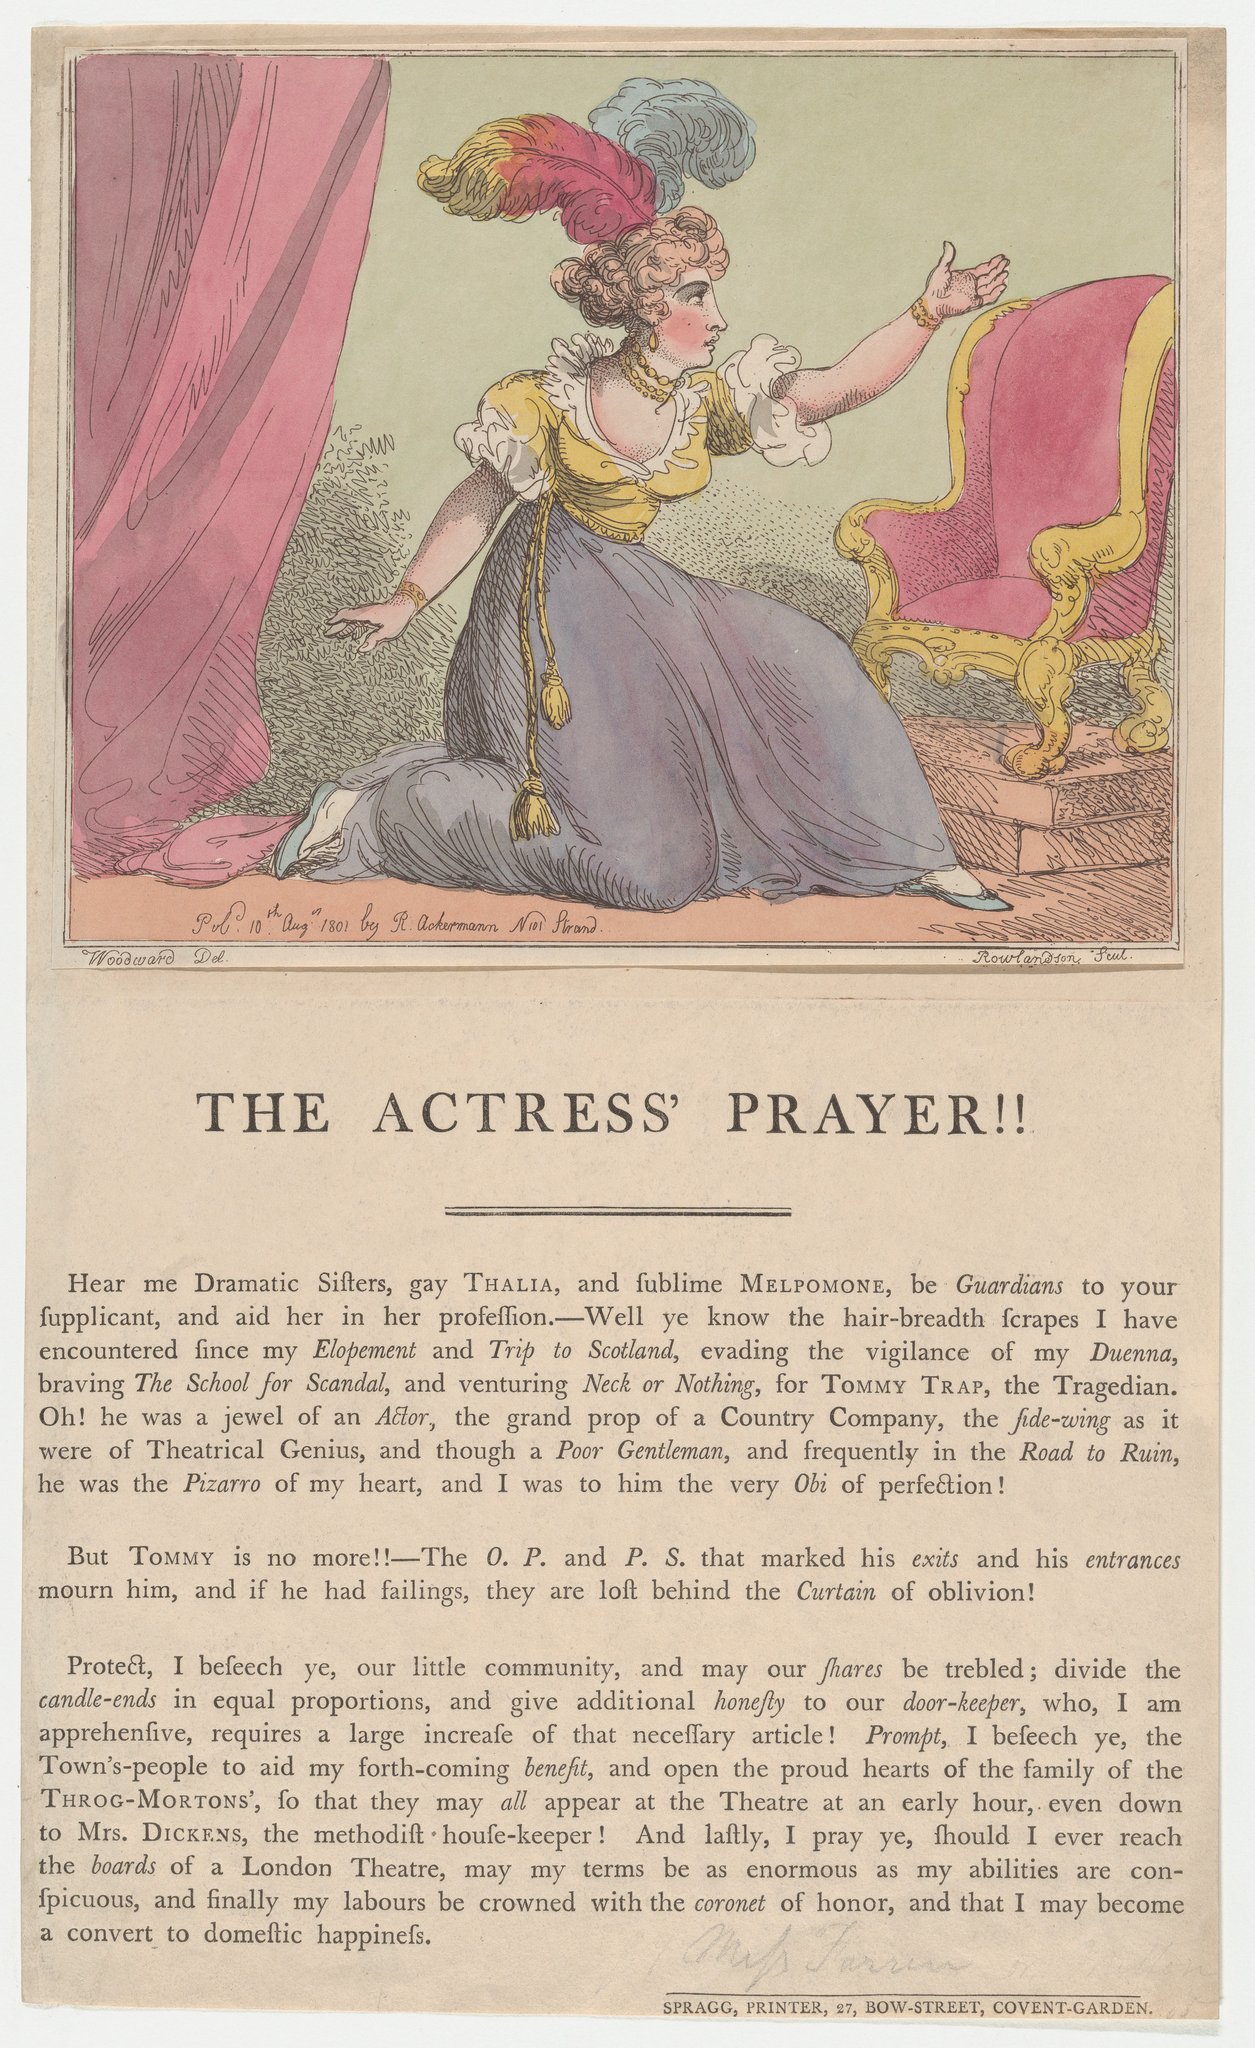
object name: print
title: The Actress' Prayer!!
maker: thomas rowlandson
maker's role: artist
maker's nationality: british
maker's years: 1757-1827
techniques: etching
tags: profiles,women,actresses